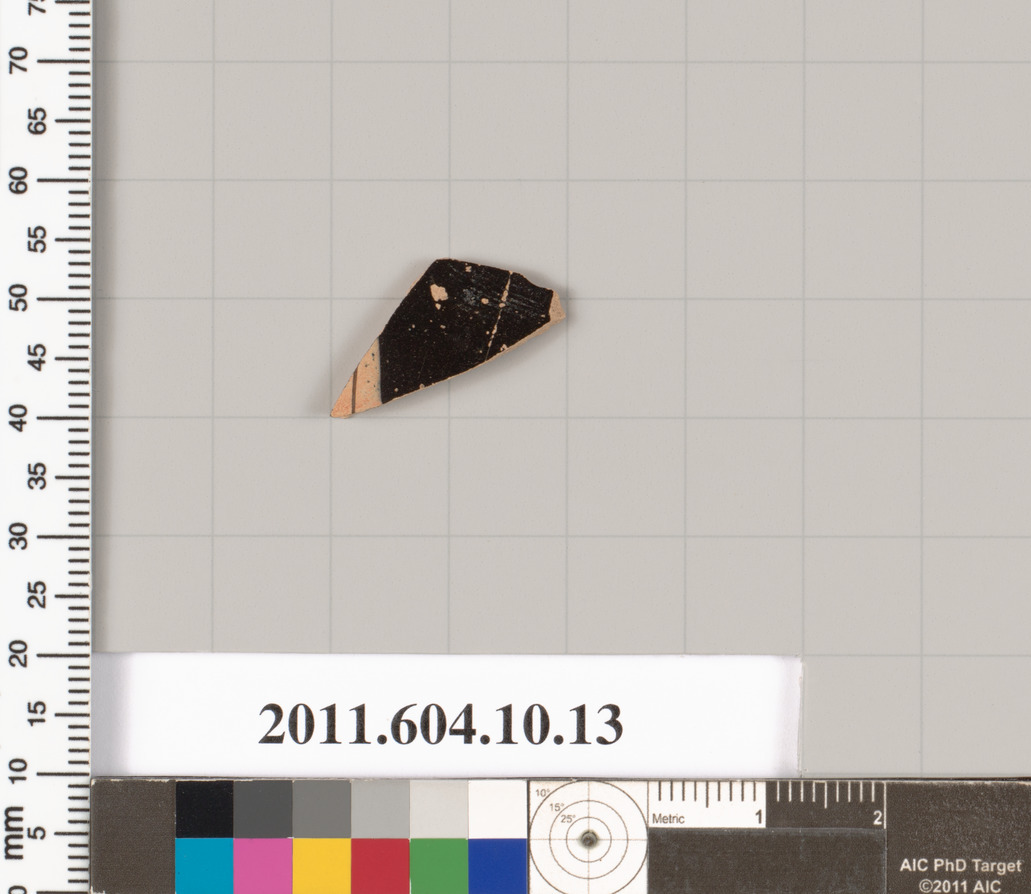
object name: kylix fragment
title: Terracotta fragment of a kylix (drinking cup)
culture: etruscan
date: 434-368 BCE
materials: terracotta